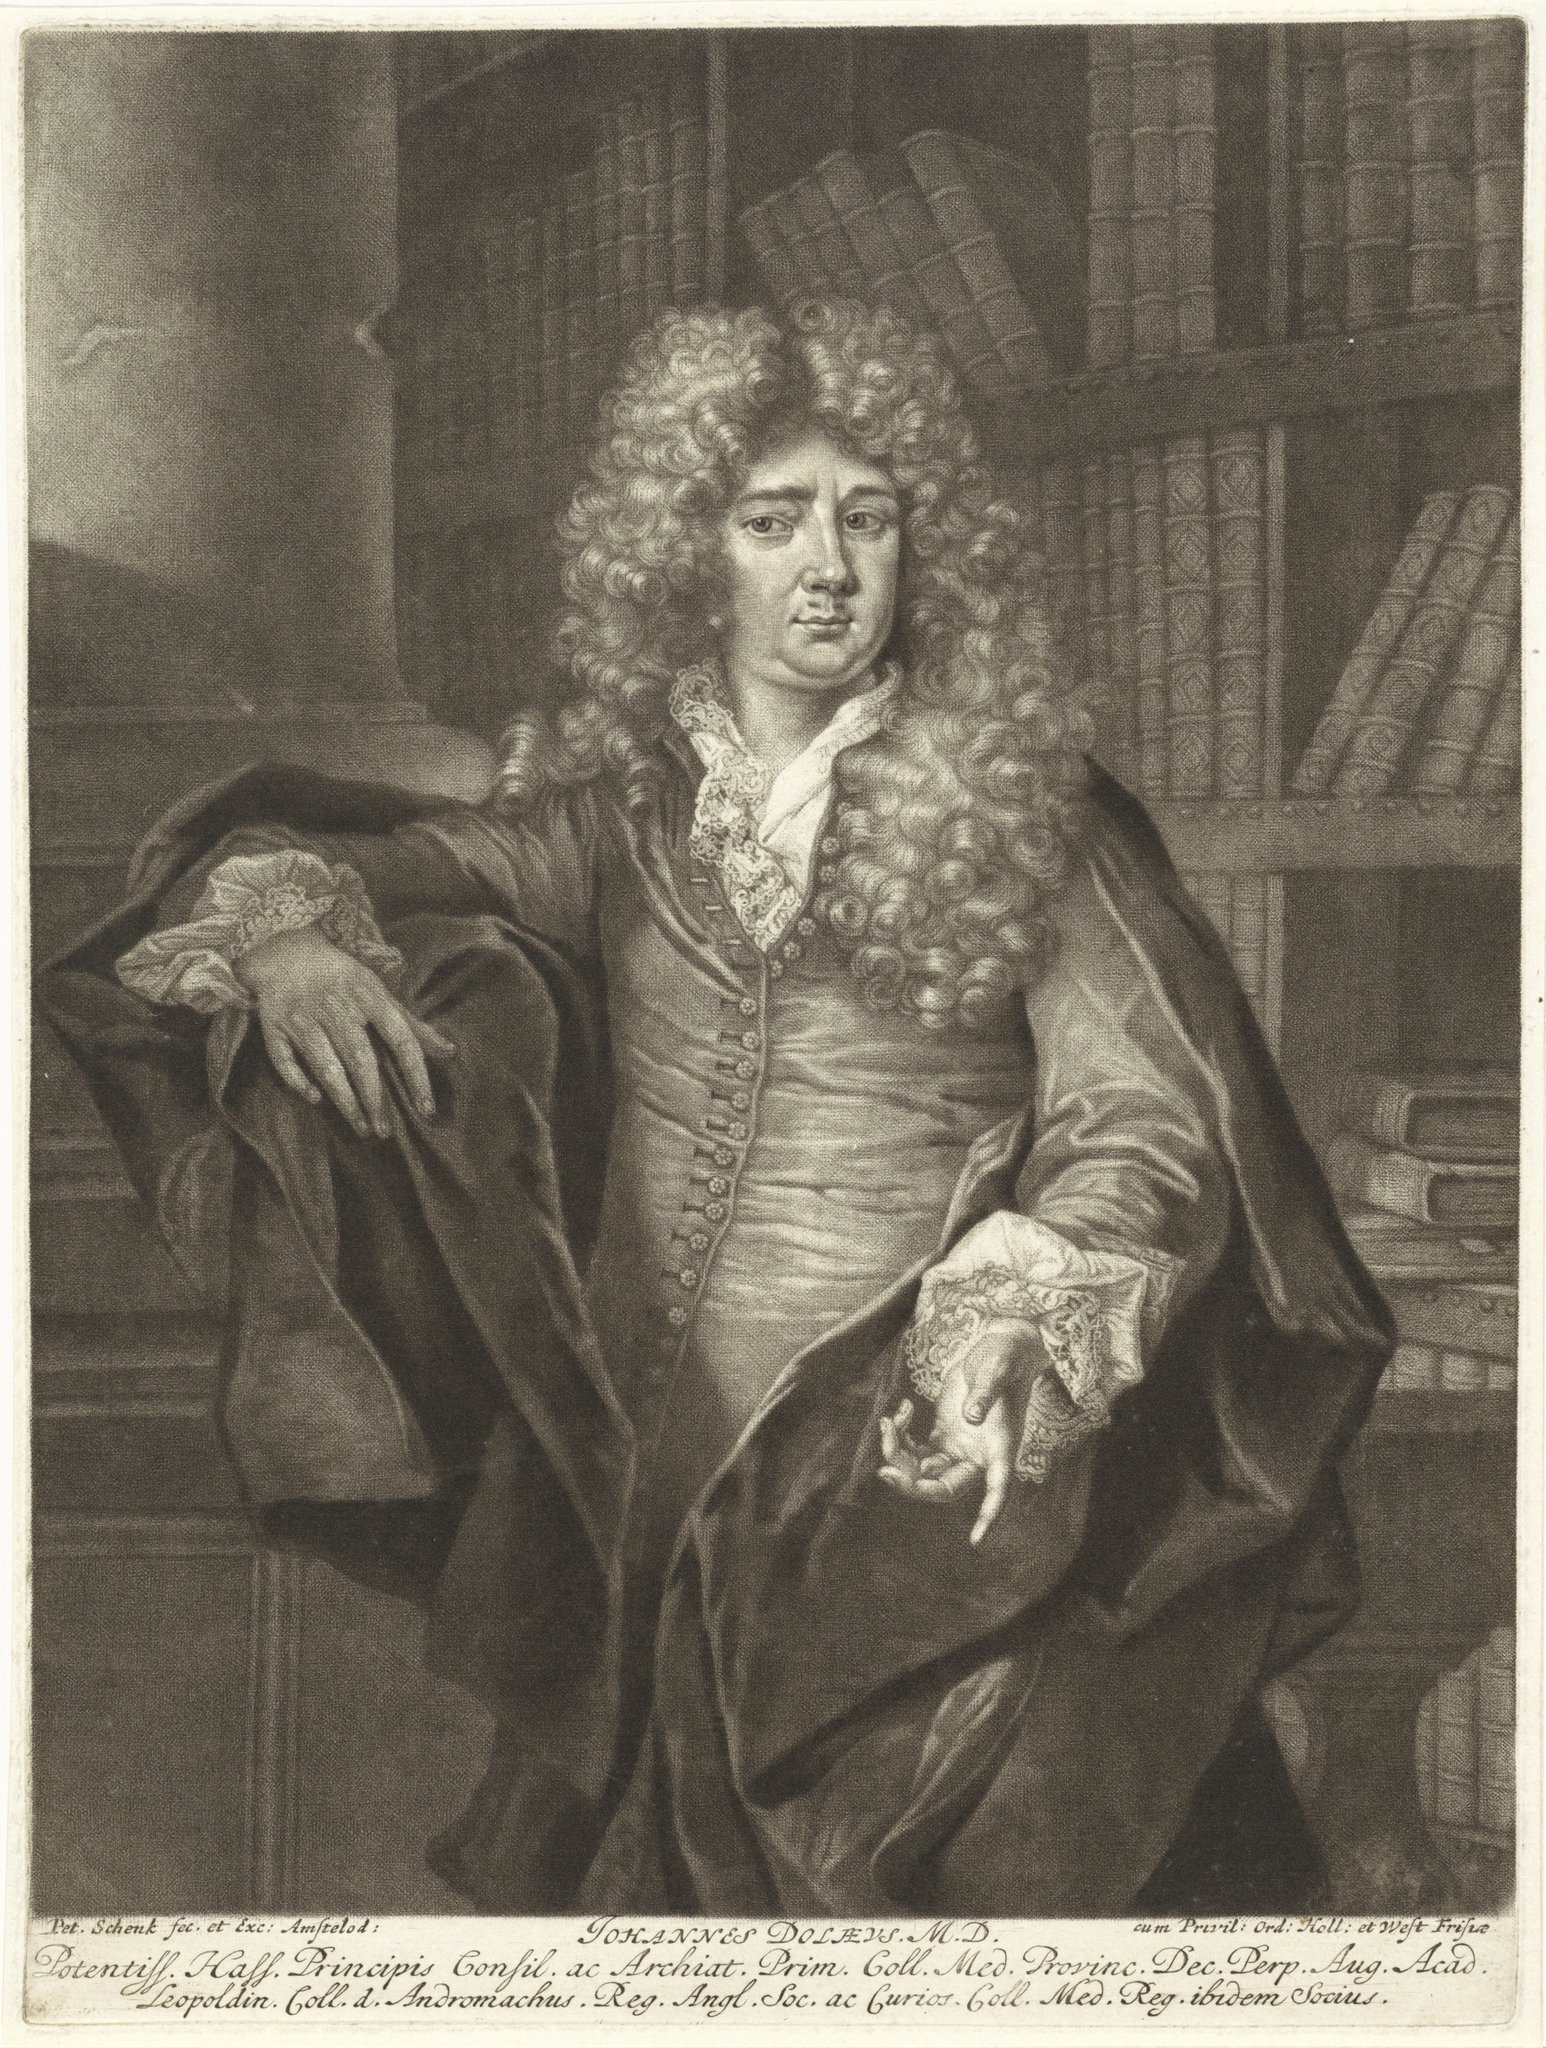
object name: print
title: Portret van Johannes Dolaeus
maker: pieter schenk (i)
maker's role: print maker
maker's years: 1660-1711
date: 1670-1713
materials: paper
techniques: engraving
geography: amsterdam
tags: book, wig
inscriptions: collector's mark: Lugt 2228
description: Johannes Dolaeus, lijfarts van Albertine van Nassau, voor een boekenkast. Hij draagt een lange krulpruik.